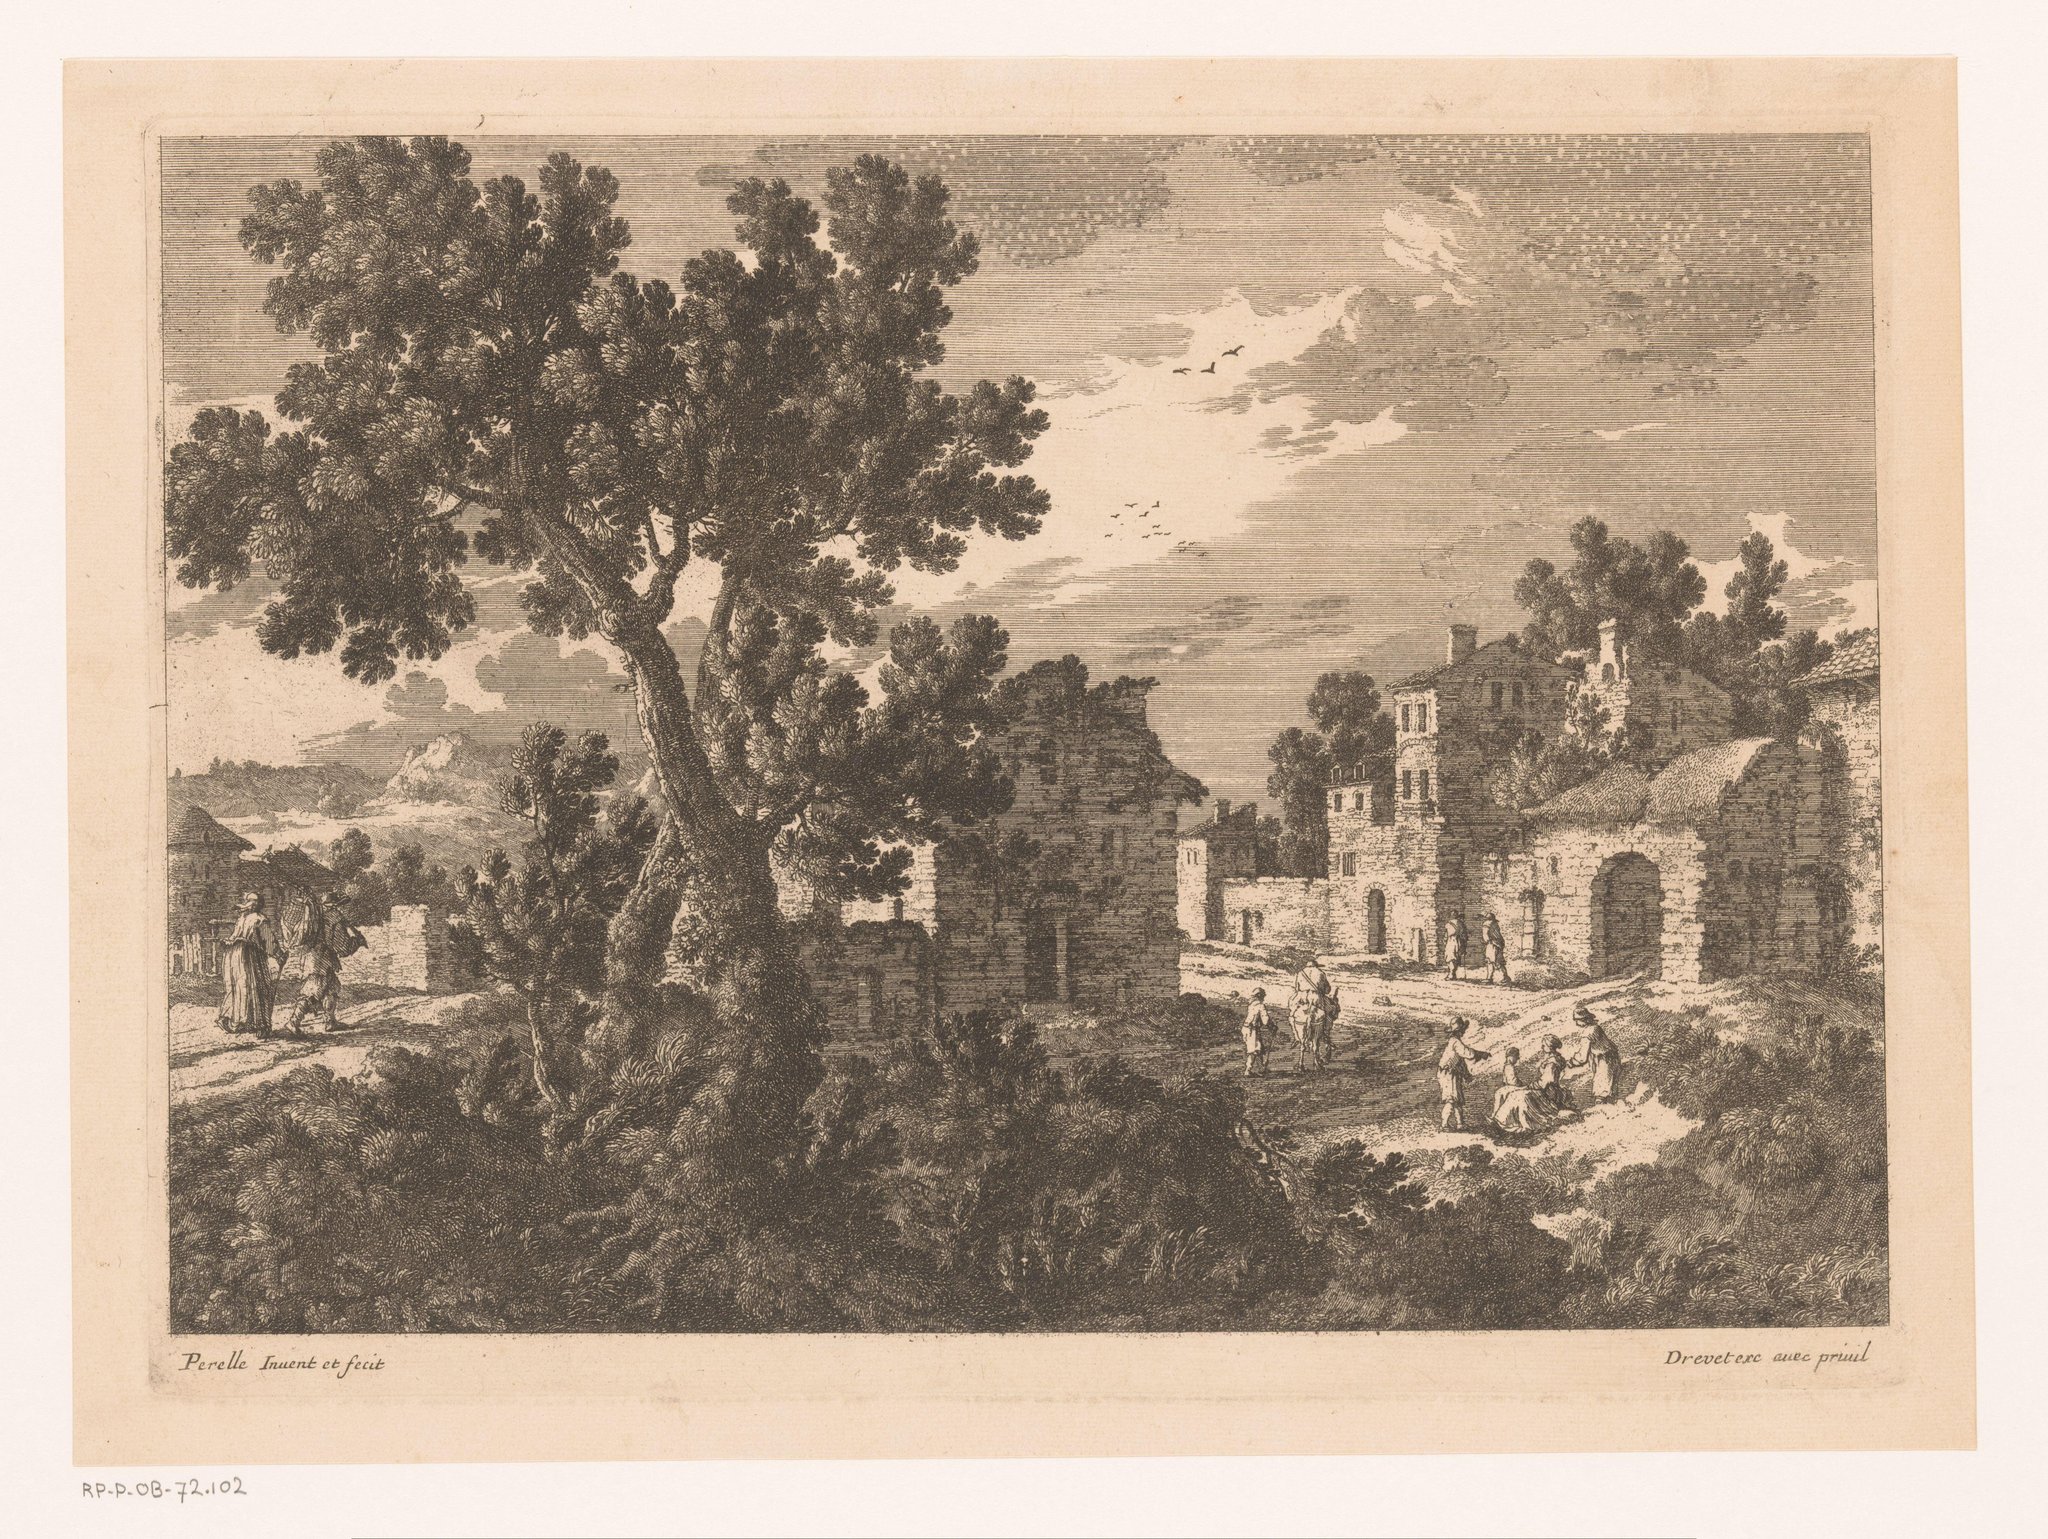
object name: print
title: Dorpsgezicht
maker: pierre drevet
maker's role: print maker, publisher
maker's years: 1663-1738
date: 1673-1695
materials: paper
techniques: etching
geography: paris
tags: village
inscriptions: collector's mark: Lugt 2228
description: Prenten met het signatuur 'Perelle' kunnen zowel door vader Gabriel als door zonen Nicolas en Adam gemaakt zijn.